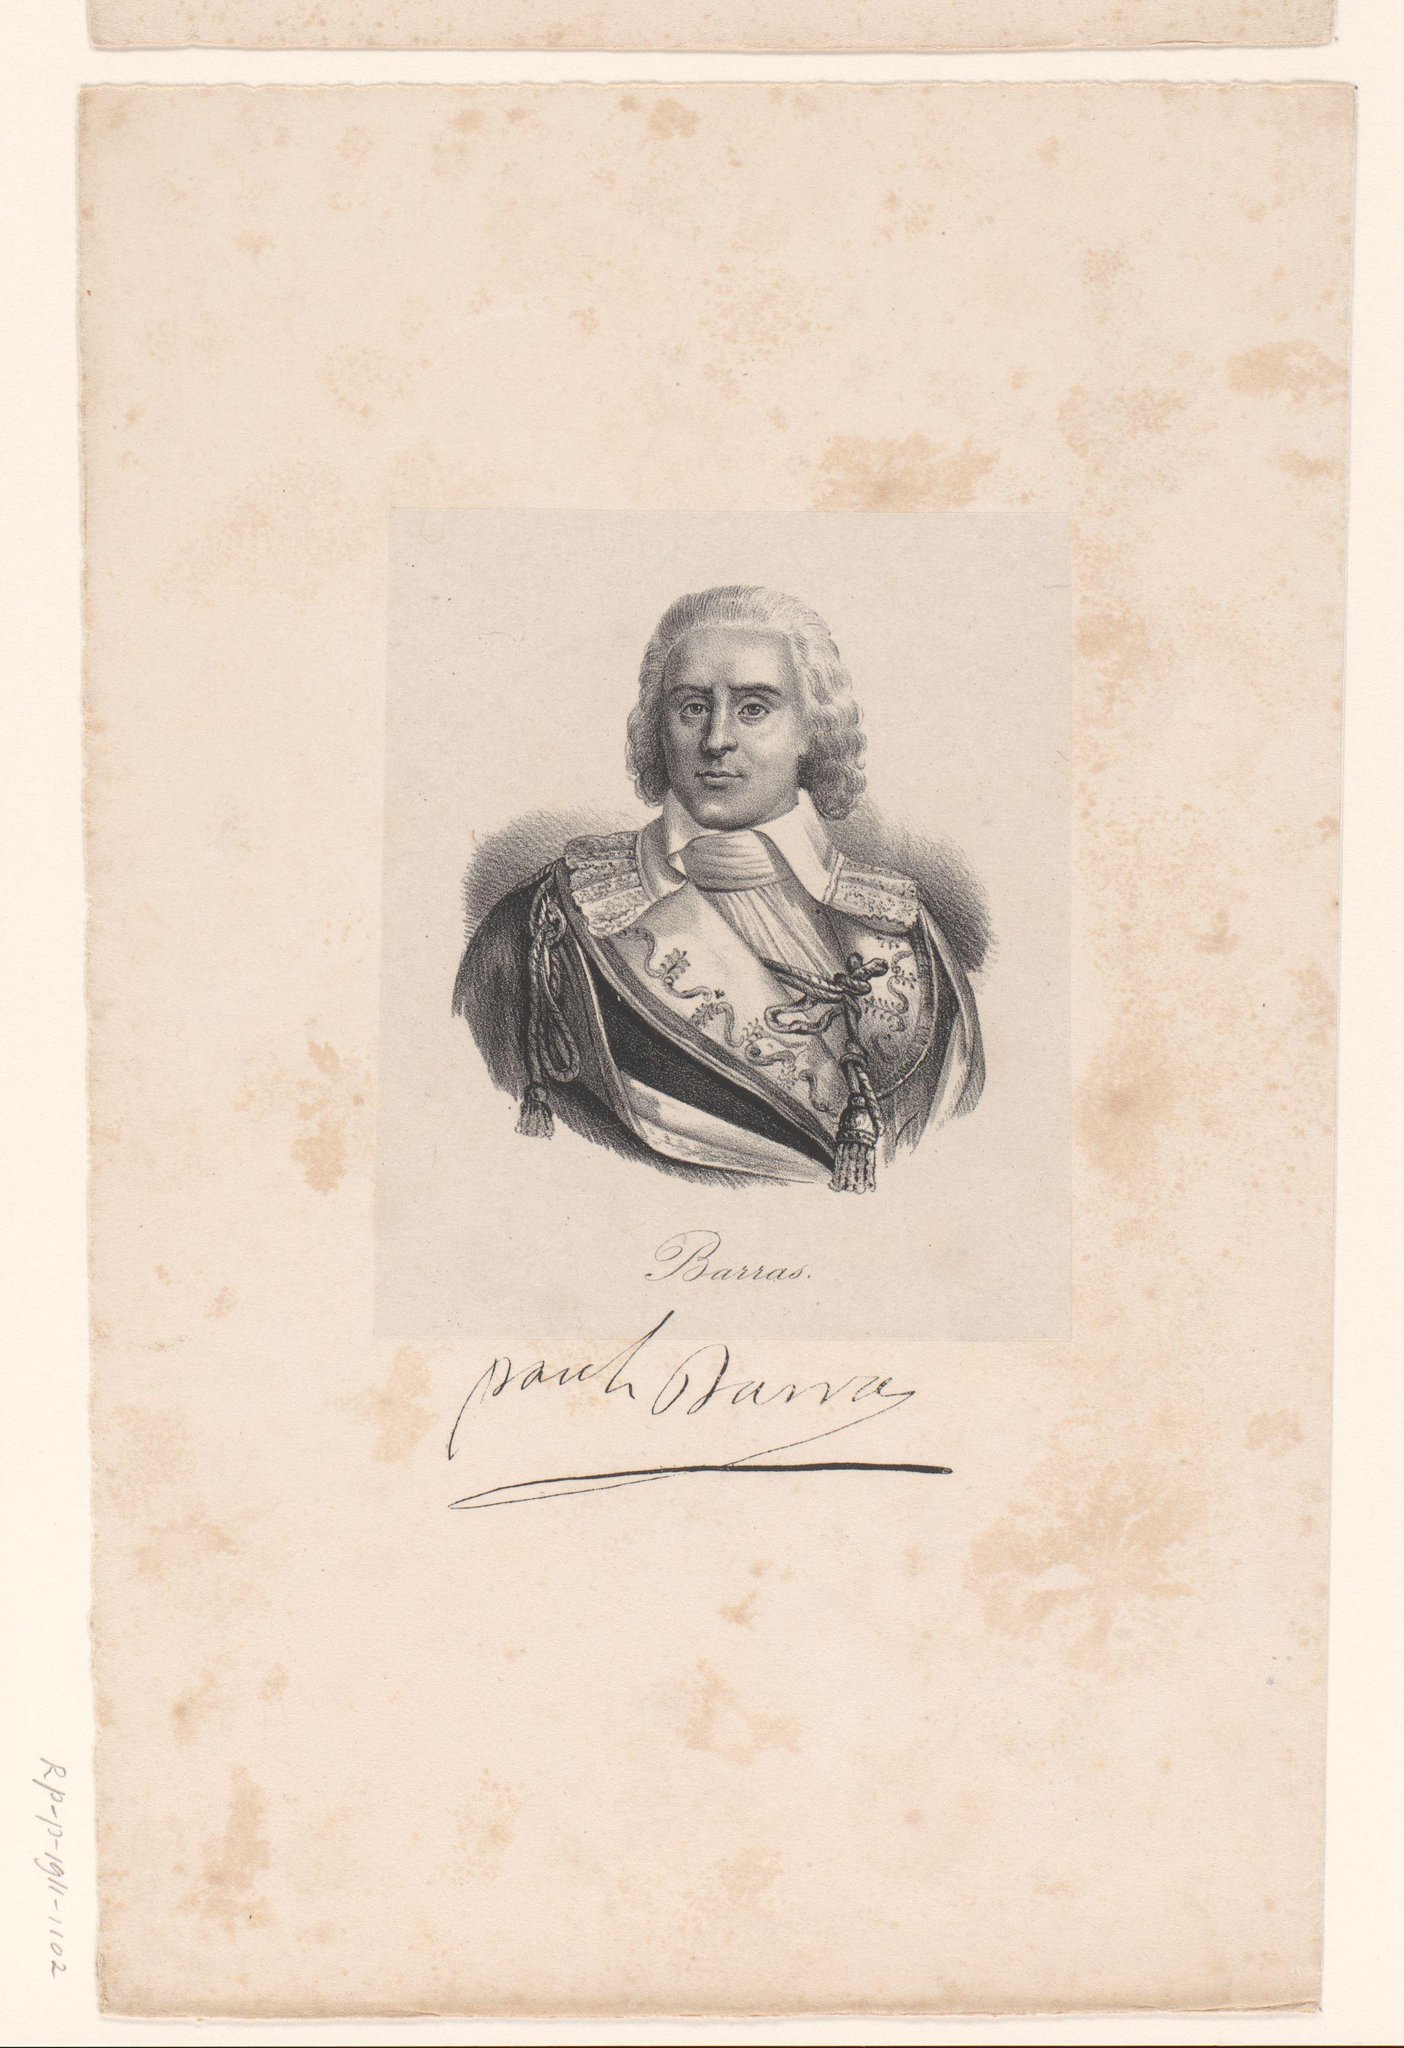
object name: print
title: Barras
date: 1818-1842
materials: paper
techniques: lithograph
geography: paris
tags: politician, historical persons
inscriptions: collector's mark: Lugt 2228a